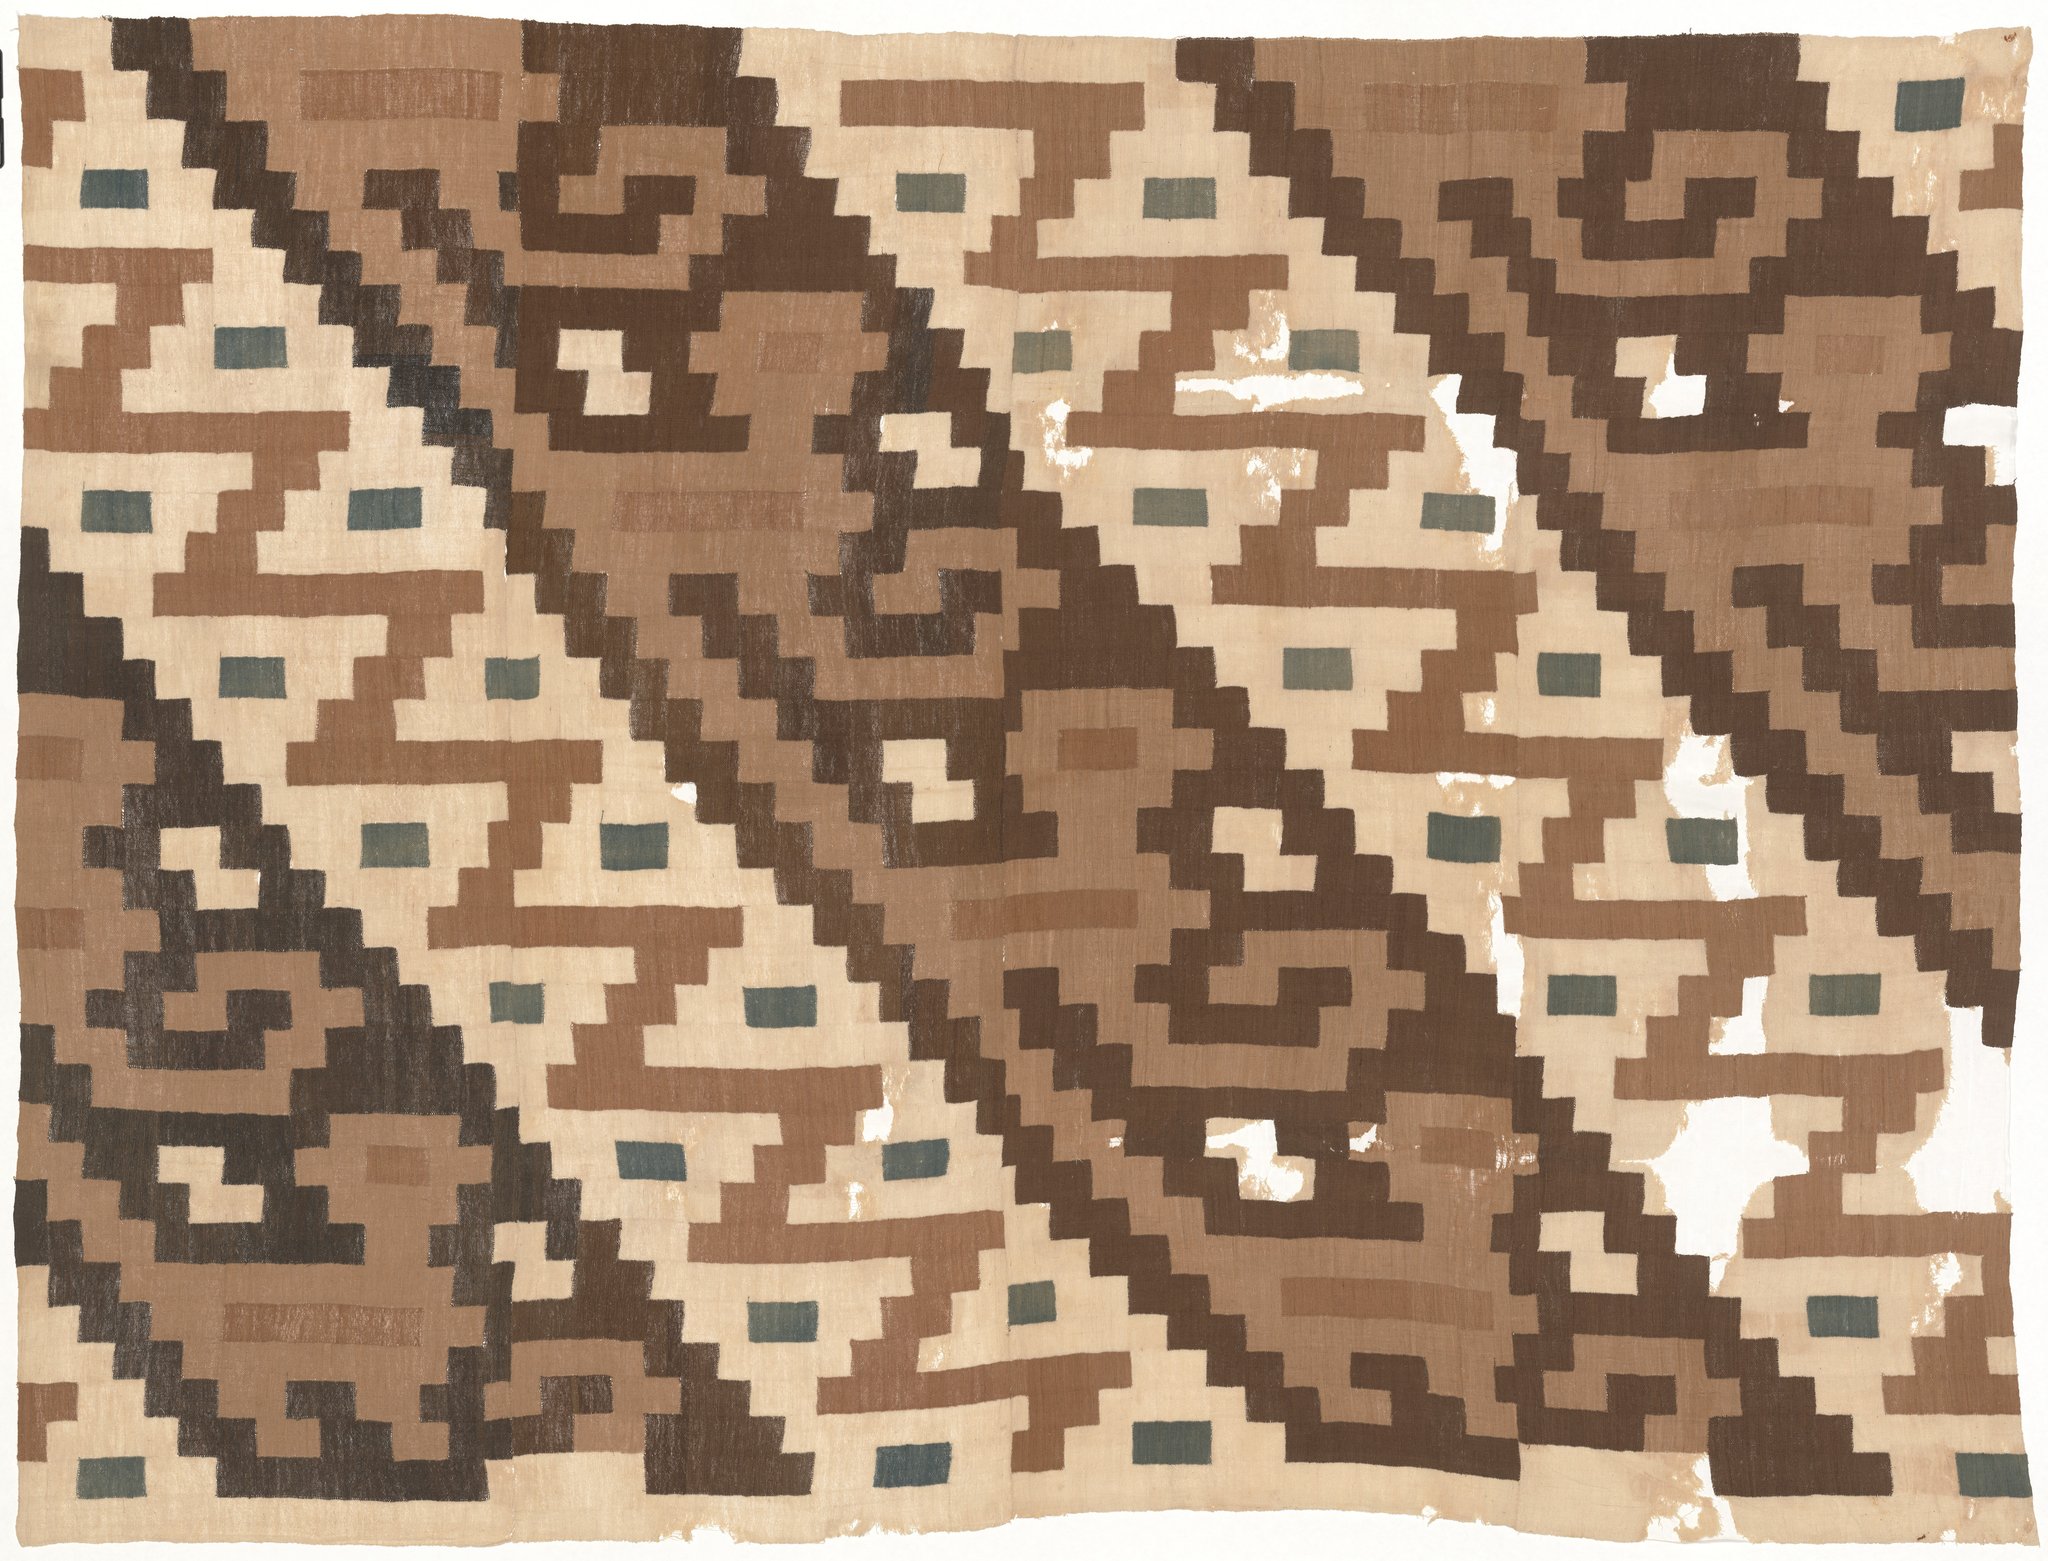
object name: hanging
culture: chimú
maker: chimú artist(s)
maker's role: artist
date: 1101-1500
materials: cotton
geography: peru